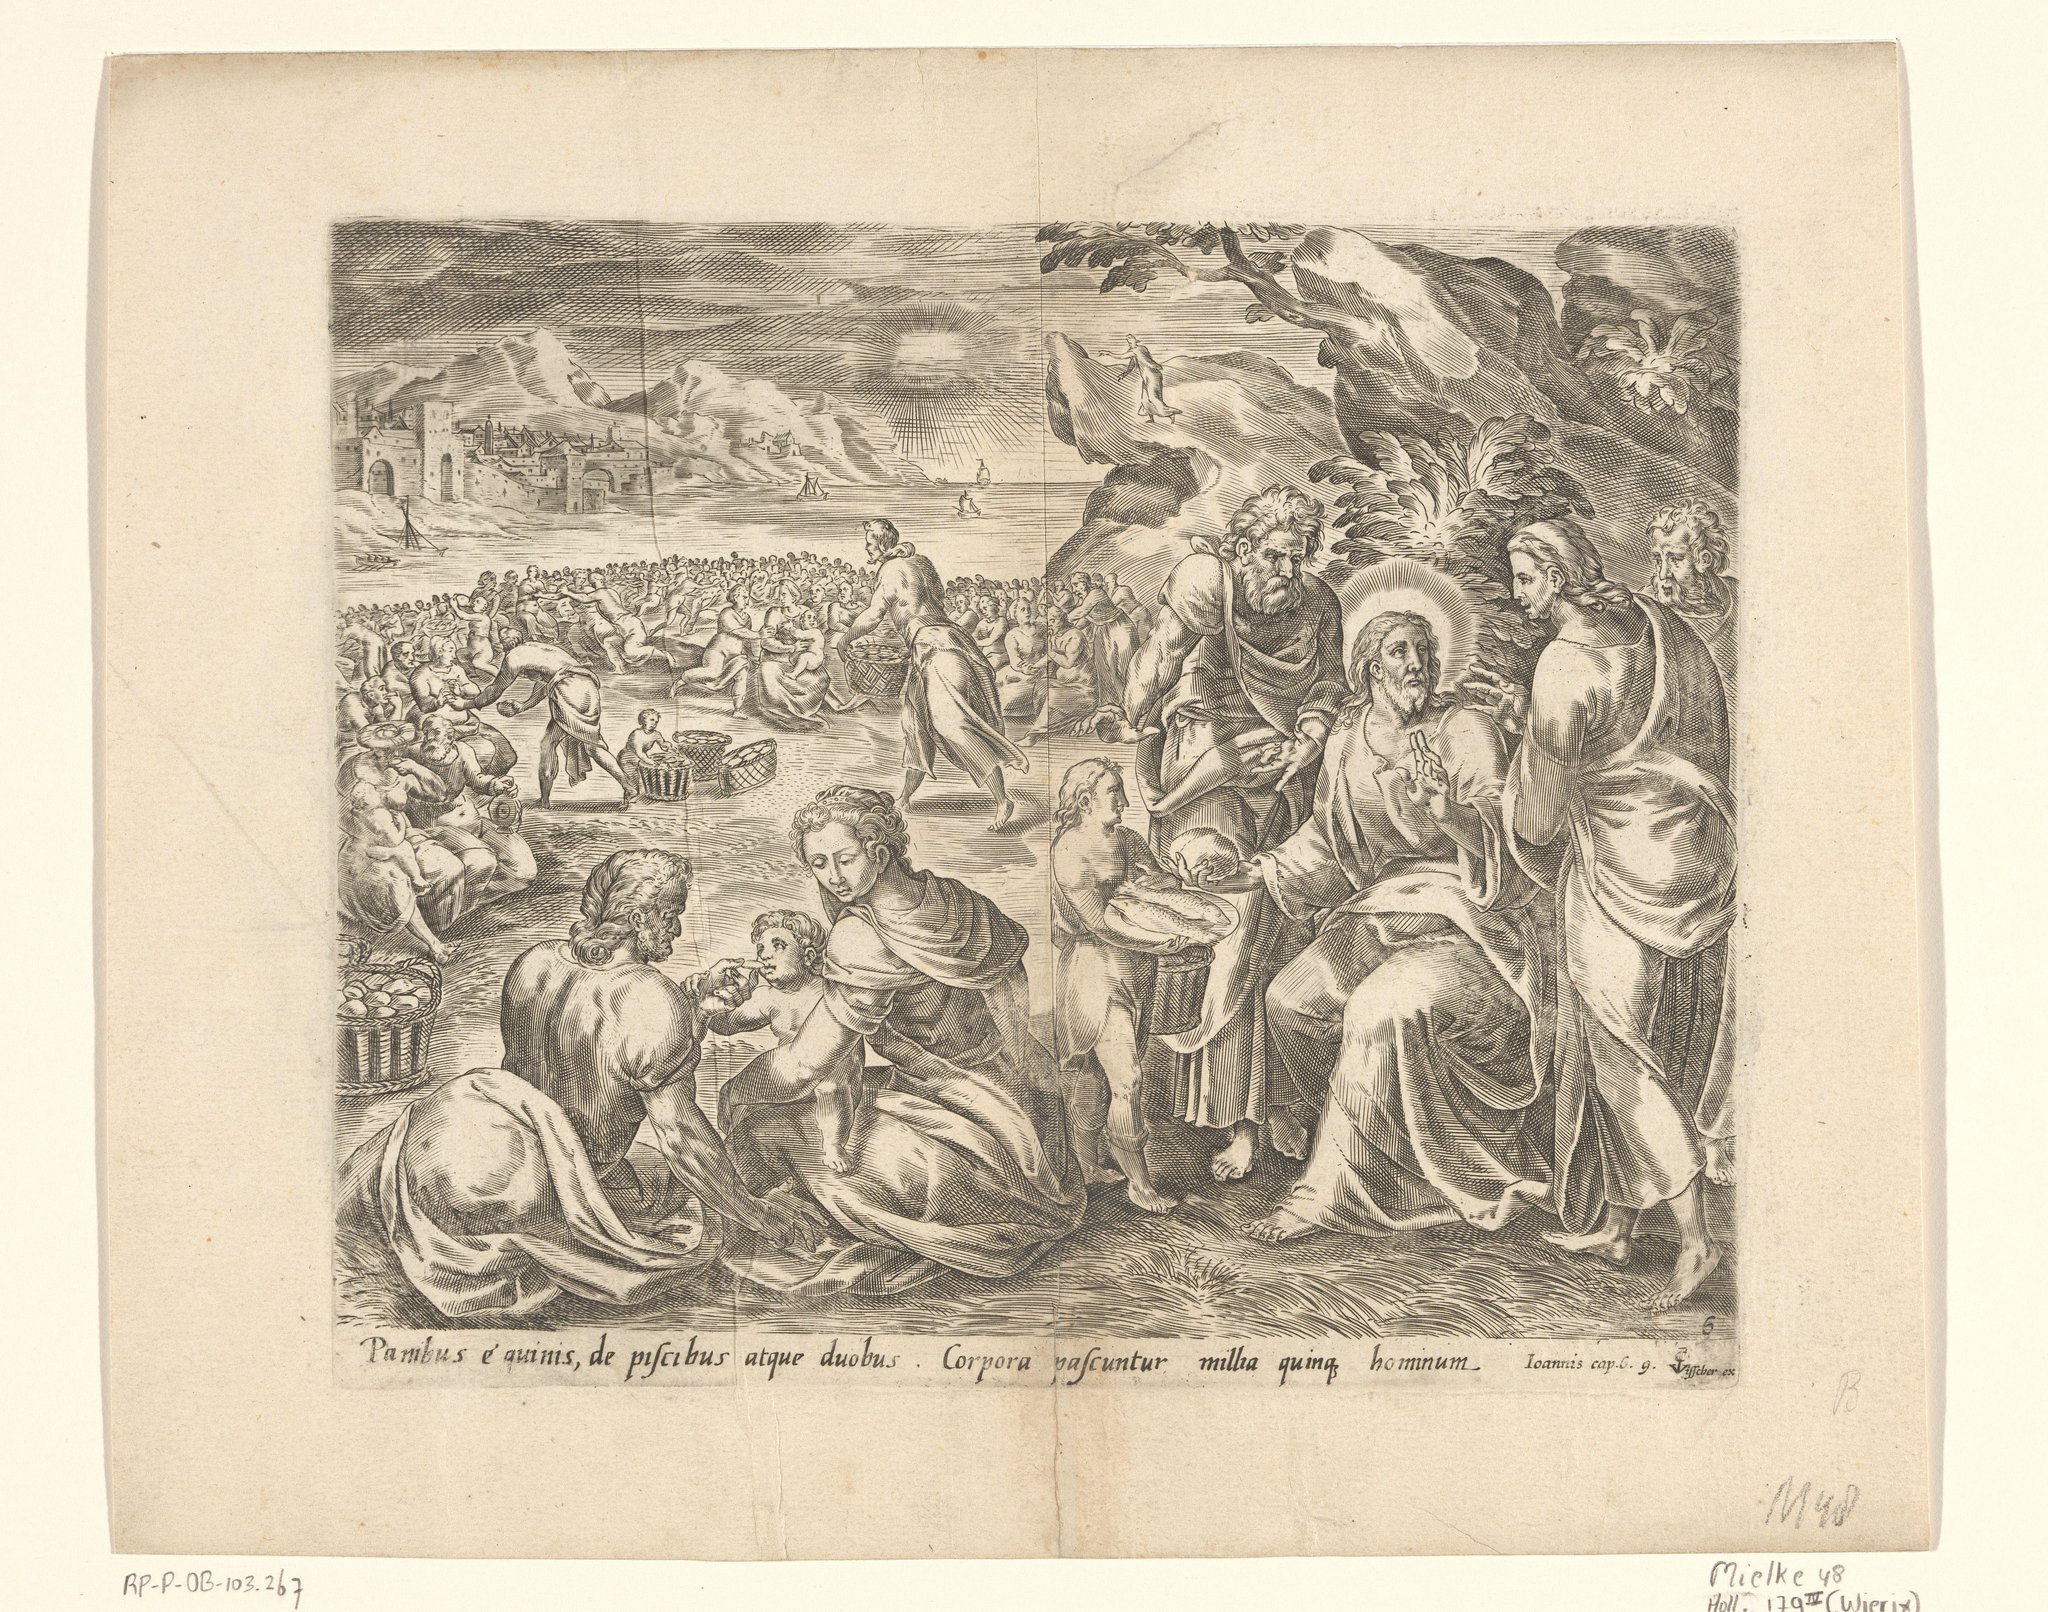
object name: print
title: Theatrum biblicum (...)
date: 1579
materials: paper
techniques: engraving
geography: amsterdam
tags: christ blessing the bread and fish brought by a boy, christ and apostles distribute bread and fish among the multitude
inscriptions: collector's mark: Lugt 2228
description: Christus zegent de broden en de vissen, die hem door een kleine jongen worden gebracht. Op de achtergrond delen de apostelen de broden en vissen uit aan de menigte. Verder naar de achtergrond een meer met zeilschepen. Onder de voorstelling een verwijzing in het Latijn naar de Bijbeltekst in Joh. 6:9.